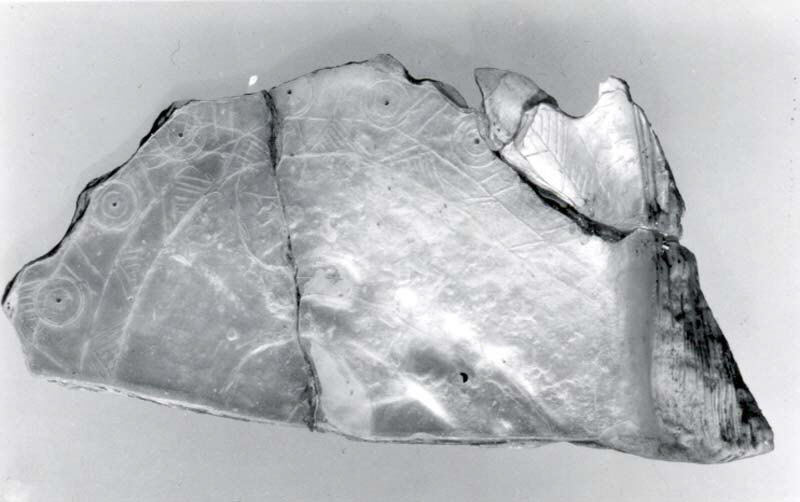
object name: shell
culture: sasanian or islamic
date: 501-800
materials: shell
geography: iran